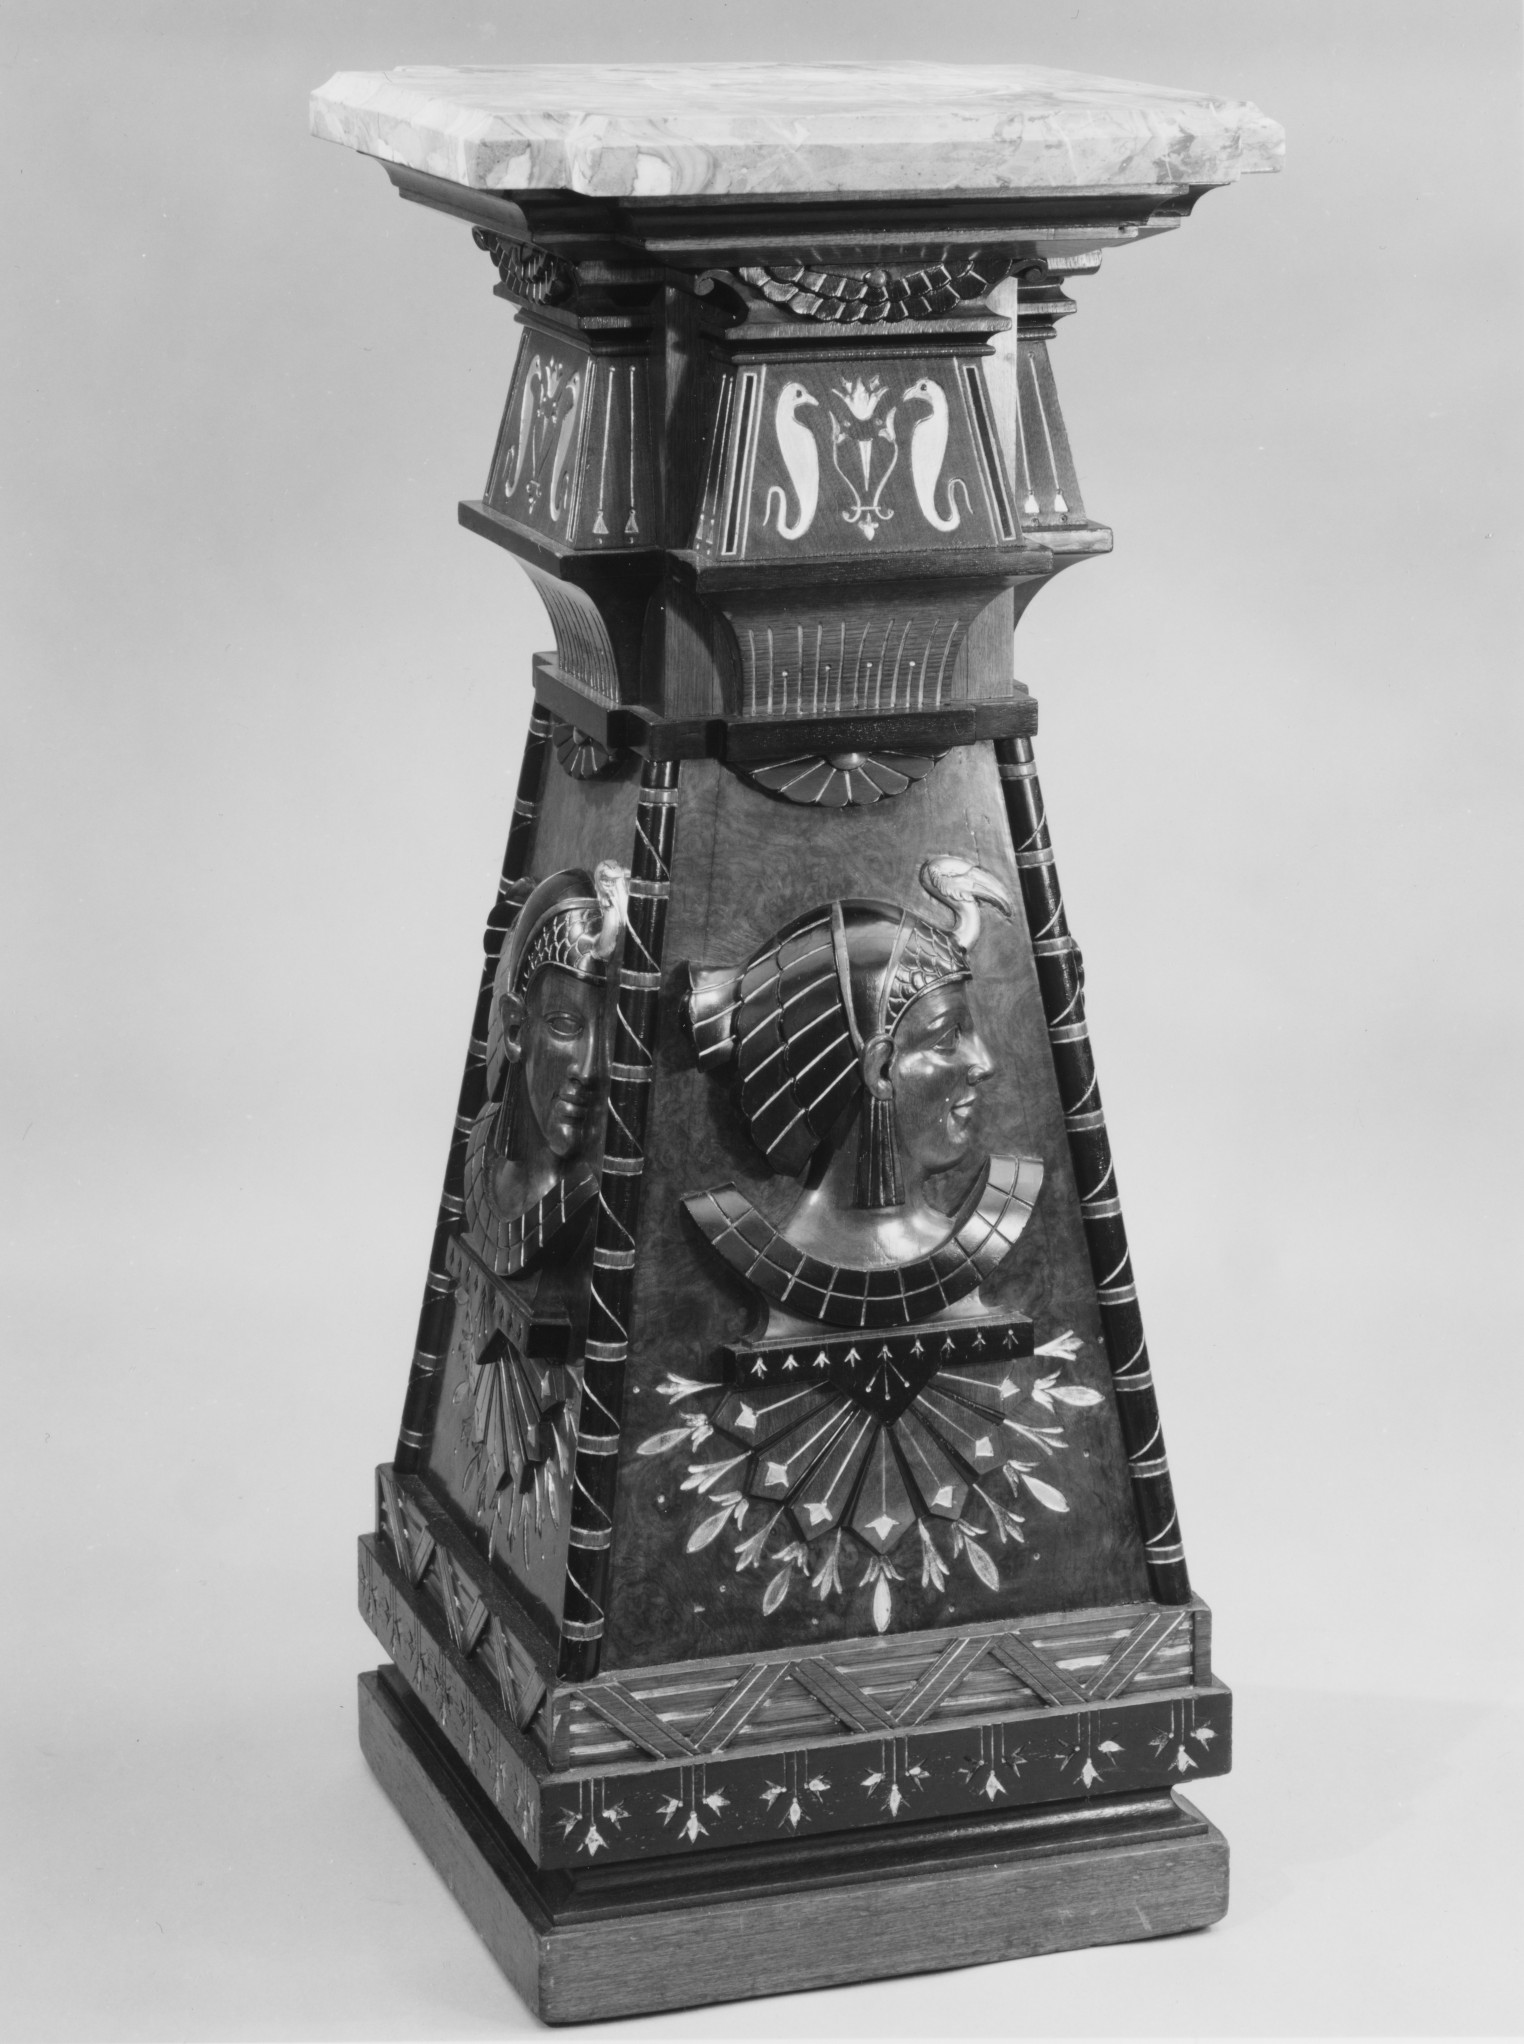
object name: pedestal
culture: american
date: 1865-1870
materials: marble, wood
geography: united states